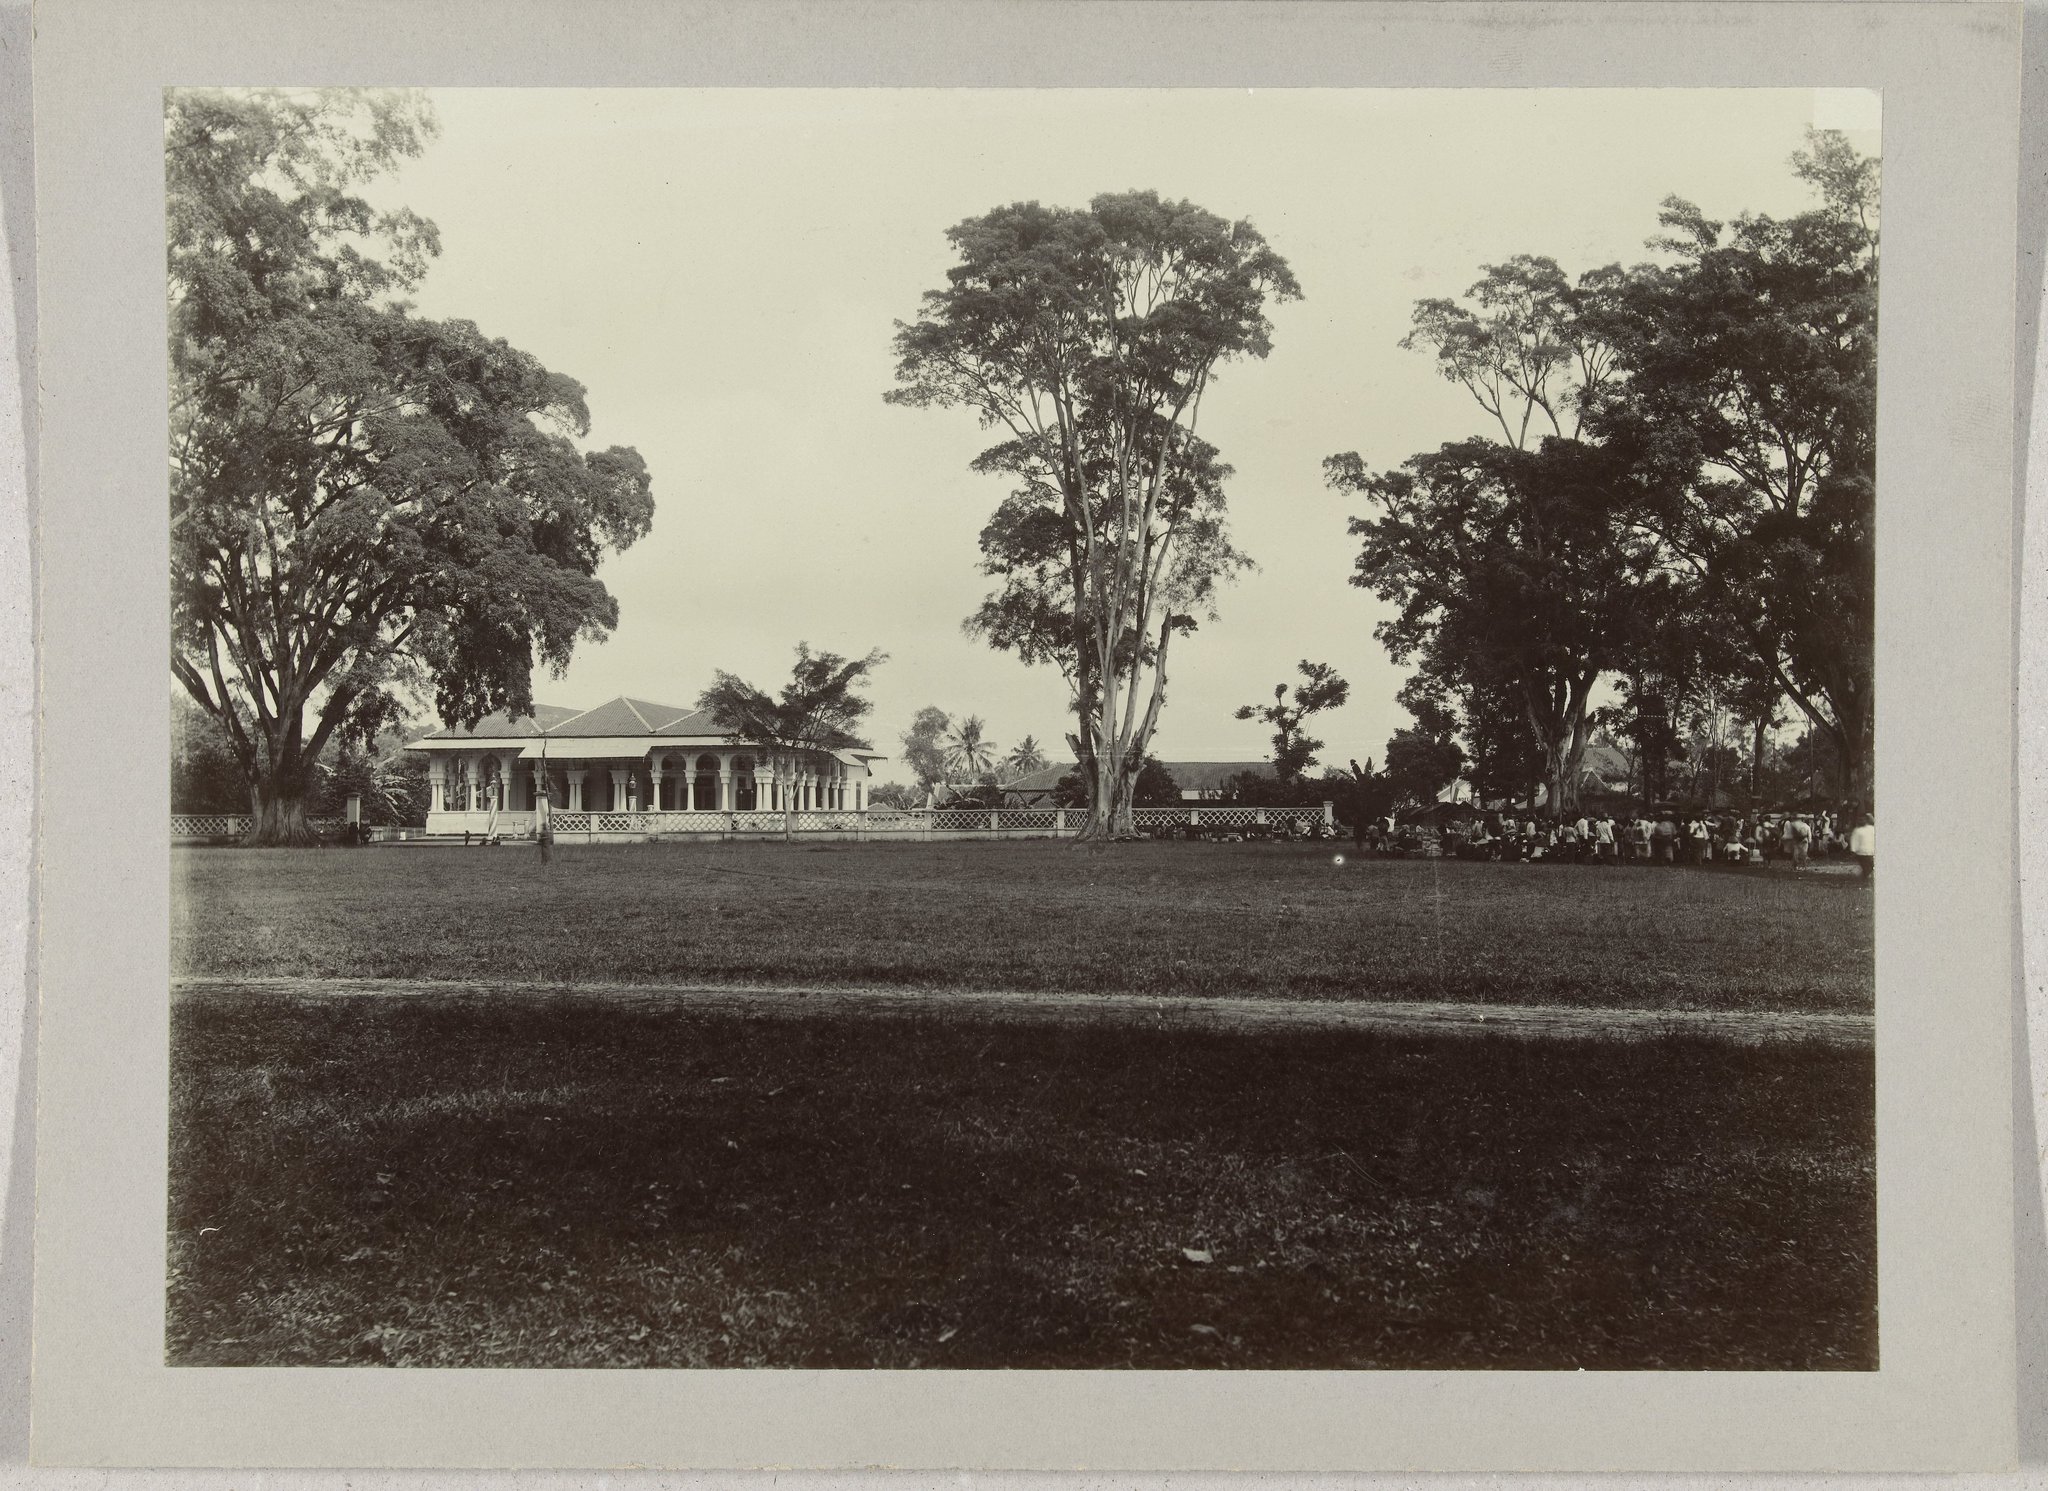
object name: photograph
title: 59. Aloen-aloen te Bandoeng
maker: Anonymous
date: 1895-1915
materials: cardboard, paper, photographic support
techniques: gelatin silver print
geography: bandung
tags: indonesia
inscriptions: annotation: ‘59. Aloen-aloen te Bandoeng’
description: Aloen-aloen (centrale plein) in Bandoeng, Nederlands-Indië